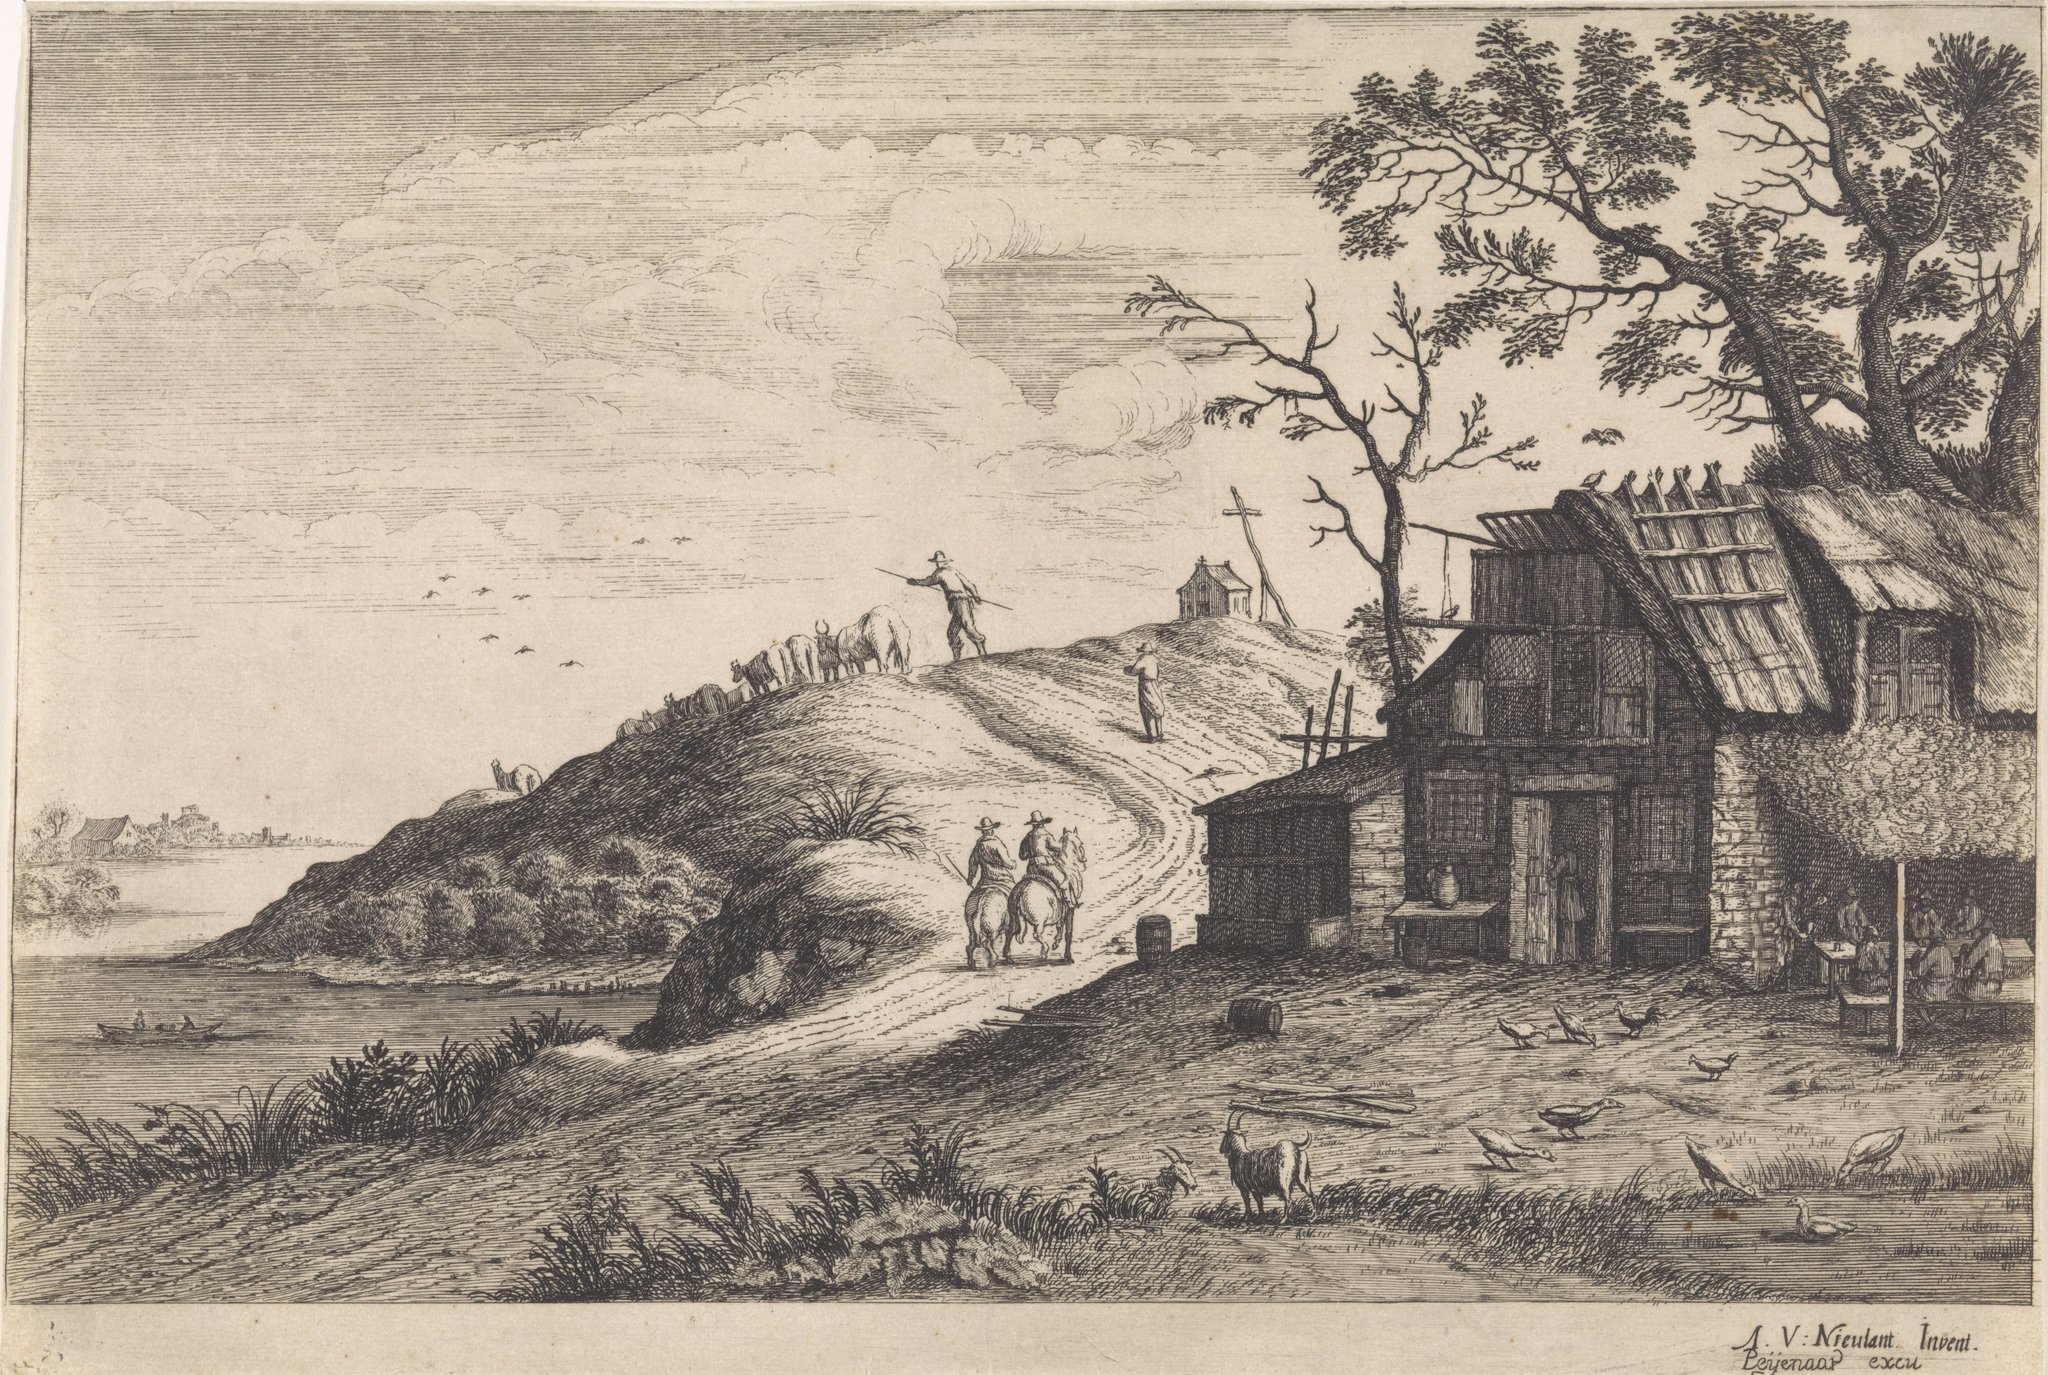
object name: print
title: Uitspanning aan een weg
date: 1623-1653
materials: paper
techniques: engraving, etching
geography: amsterdam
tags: inn, coffee-house, public house, etc., water course, road, path, cattle driving, cattle driver, church (exterior) - qq - small church, chapel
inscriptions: collector's mark: Lugt 240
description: Uitspanning met overkapping, waaronder een gezelschap aan tafel. Op de weg gaan twee ruiters en een veedrijver met zijn vee. Op de heuvel staat een kapel, op het water vaart een bootje. Prent uit een serie landschappen.